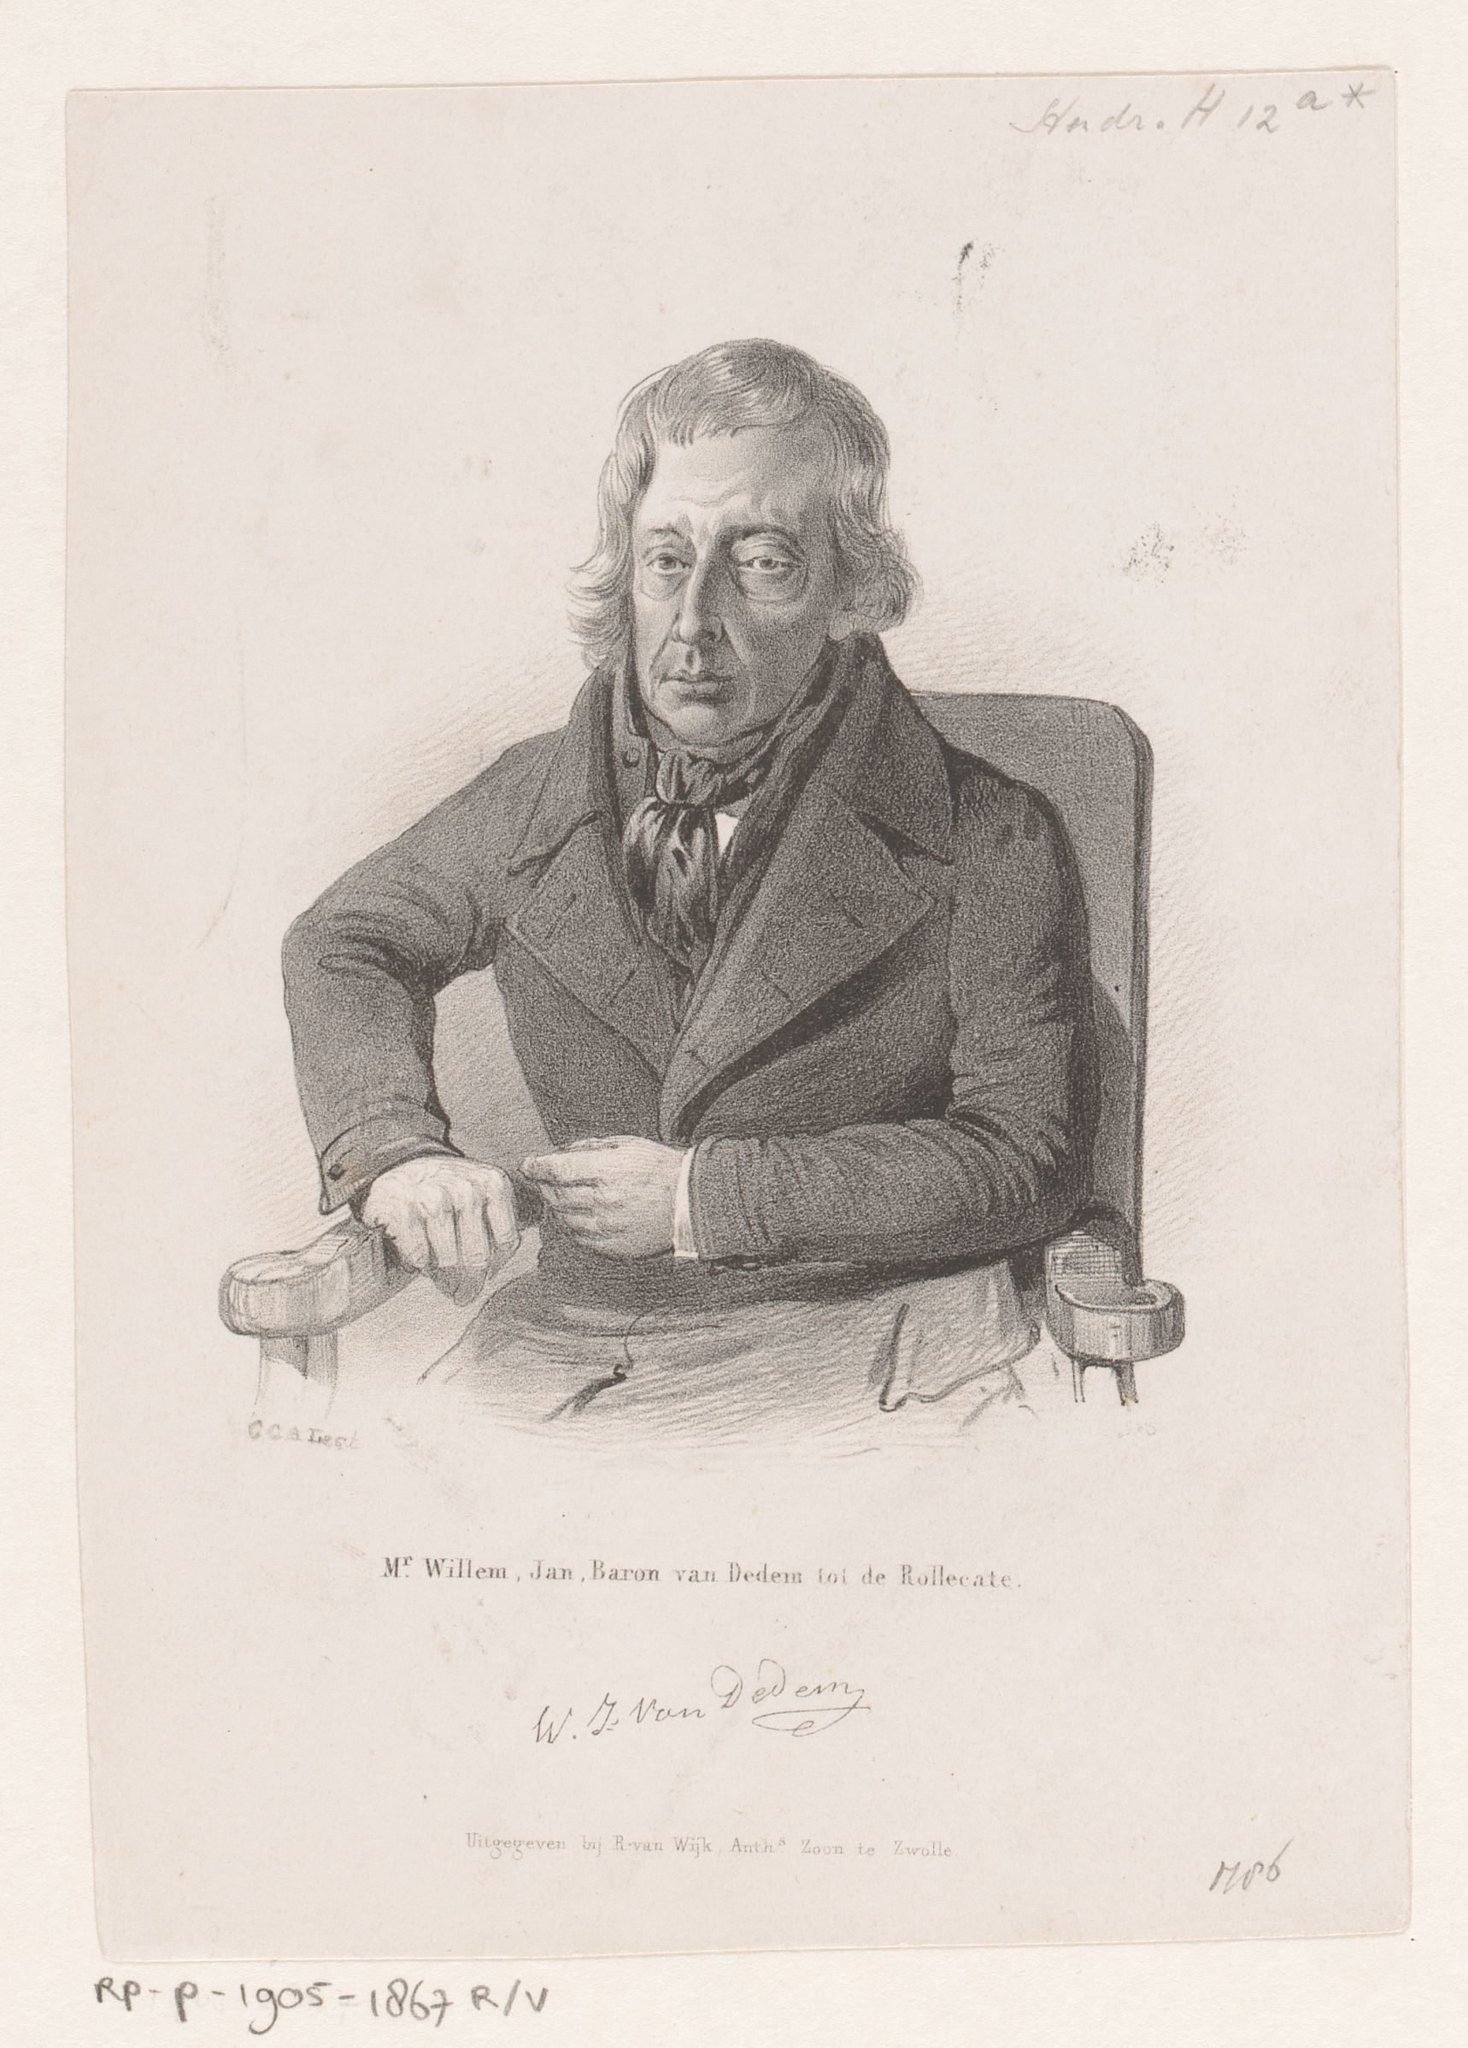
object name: print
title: Portret van Willem Jan baron van Dedem tot de Rollecate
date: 1842-1887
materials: paper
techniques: lithograph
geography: the hague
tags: historical persons (+ half-length portrait)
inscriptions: collector's mark: Lugt 2228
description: De geportretteerde zit in een stoel. Met zijn rechterhand steunt hij op de armleuning. Onder het portret zijn naam en signatuur.